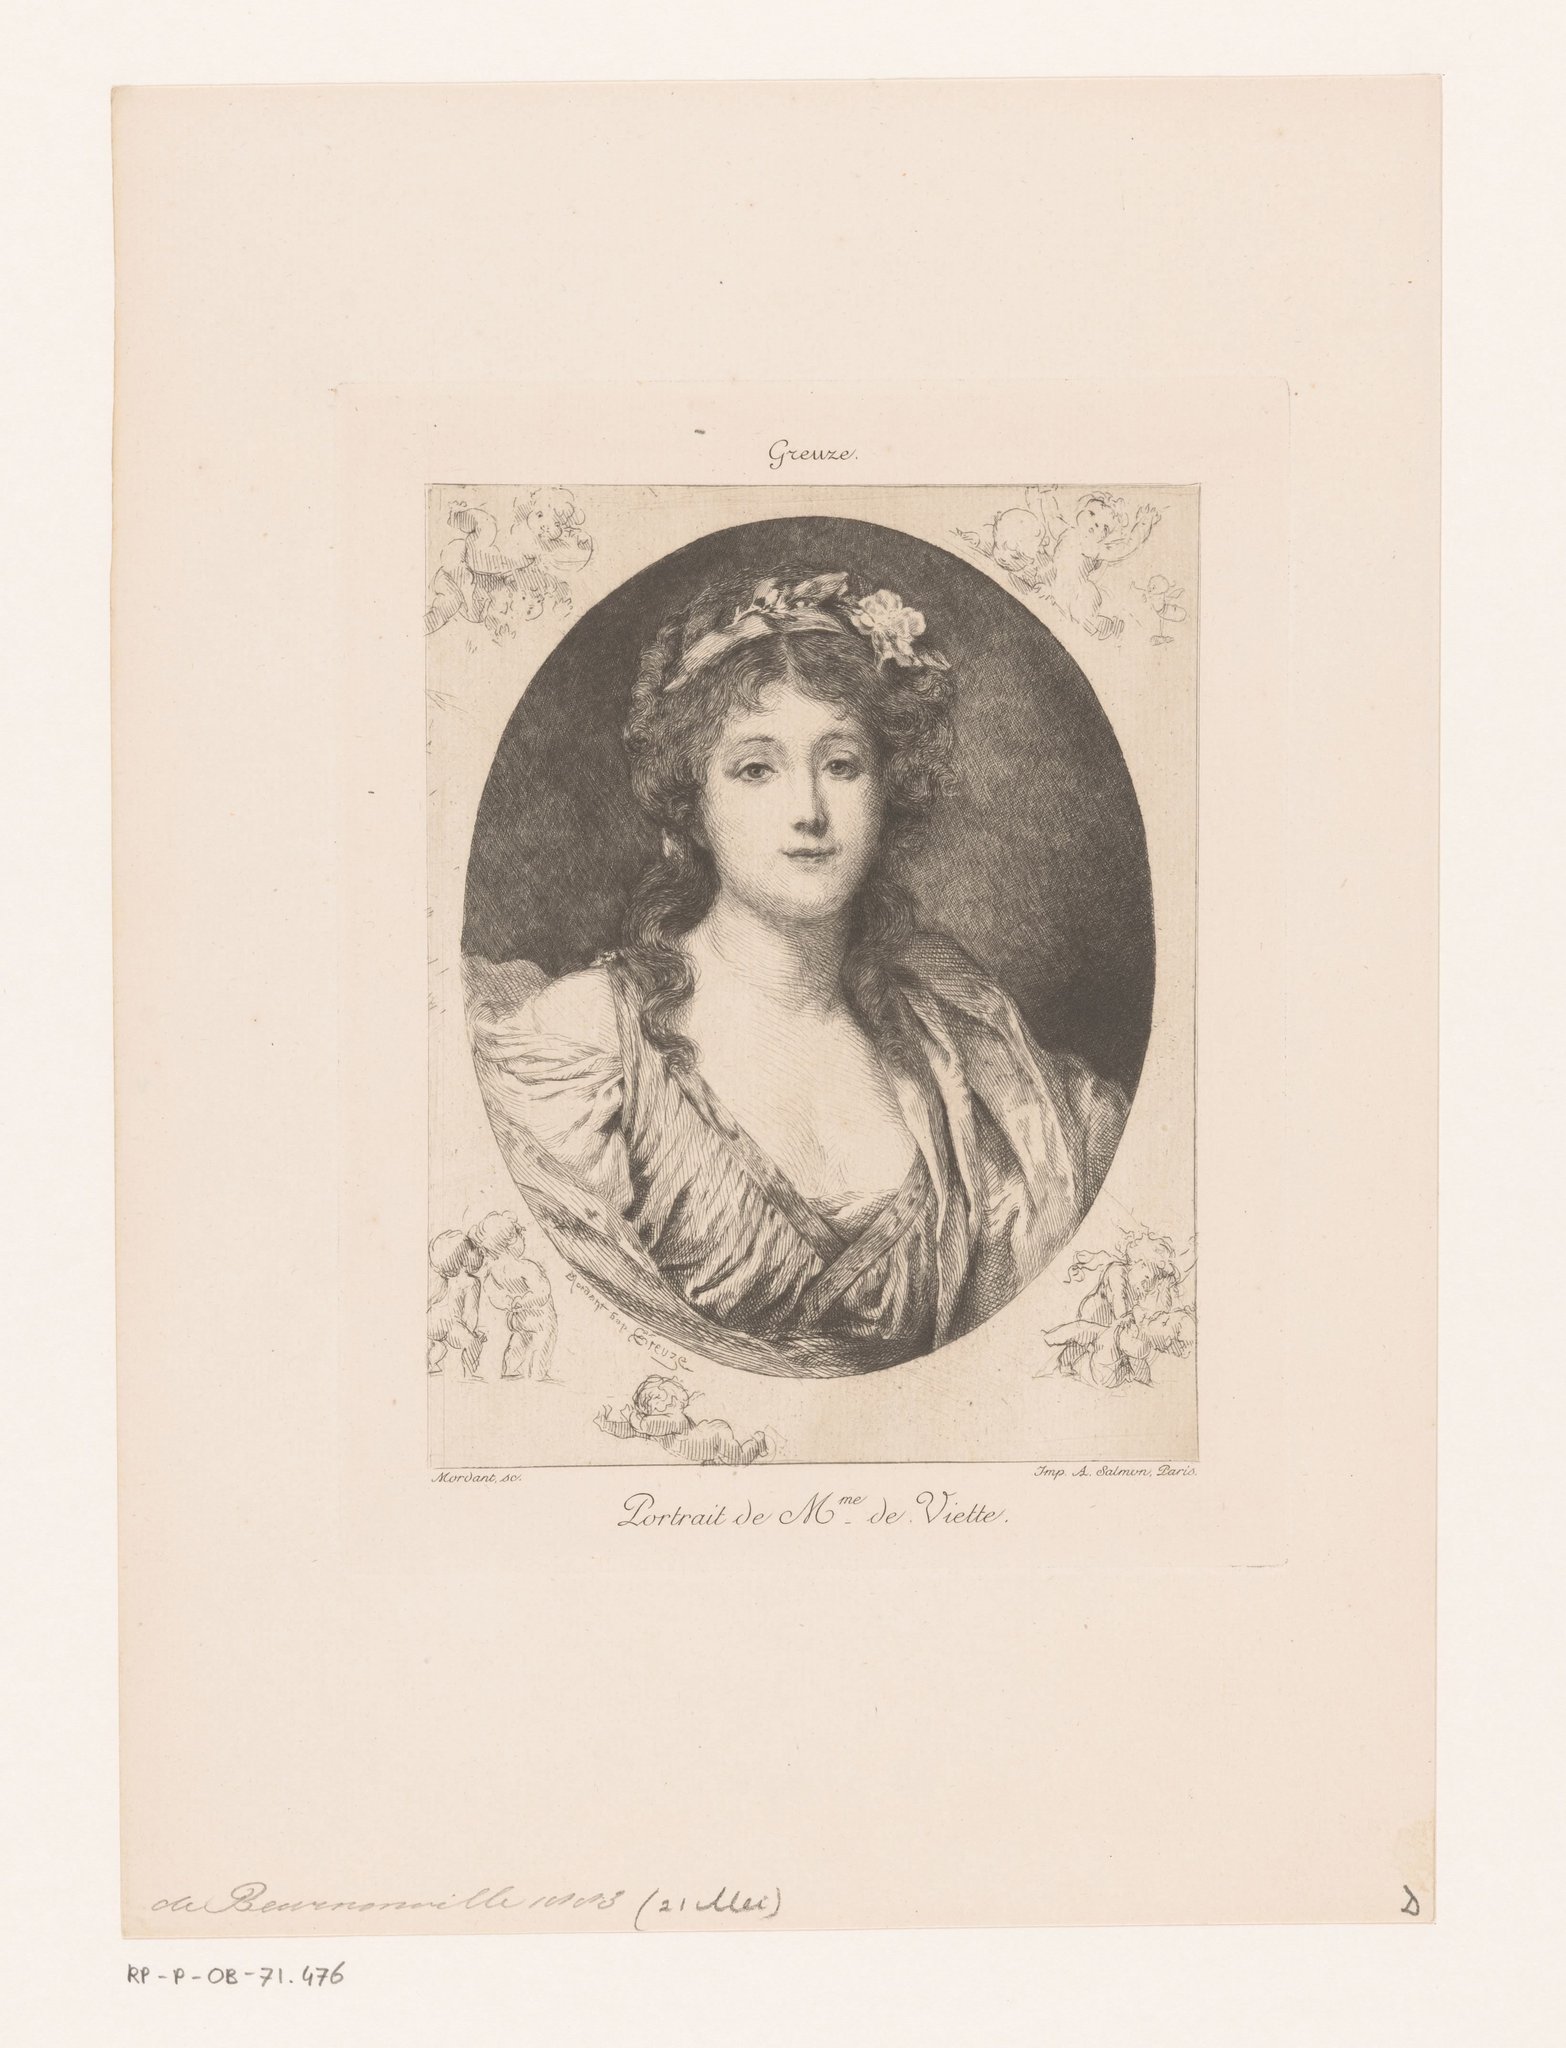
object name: print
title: Portret van Madame de Viette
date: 1881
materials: paper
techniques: etching, intaglio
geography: paris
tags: historical persons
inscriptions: collector's mark: Lugt 2228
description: Prent afkomstig uit een veilingcatalogus: "Catalogue des Tableaux anciens composant la très importante collection de Monsieur le Baron de Beurnonville", uitgegeven in 1881 te Parijs door Pillet en Dumoulin. De veiling vond plaats op 9 tot en met 14 en 16 mei 1881.